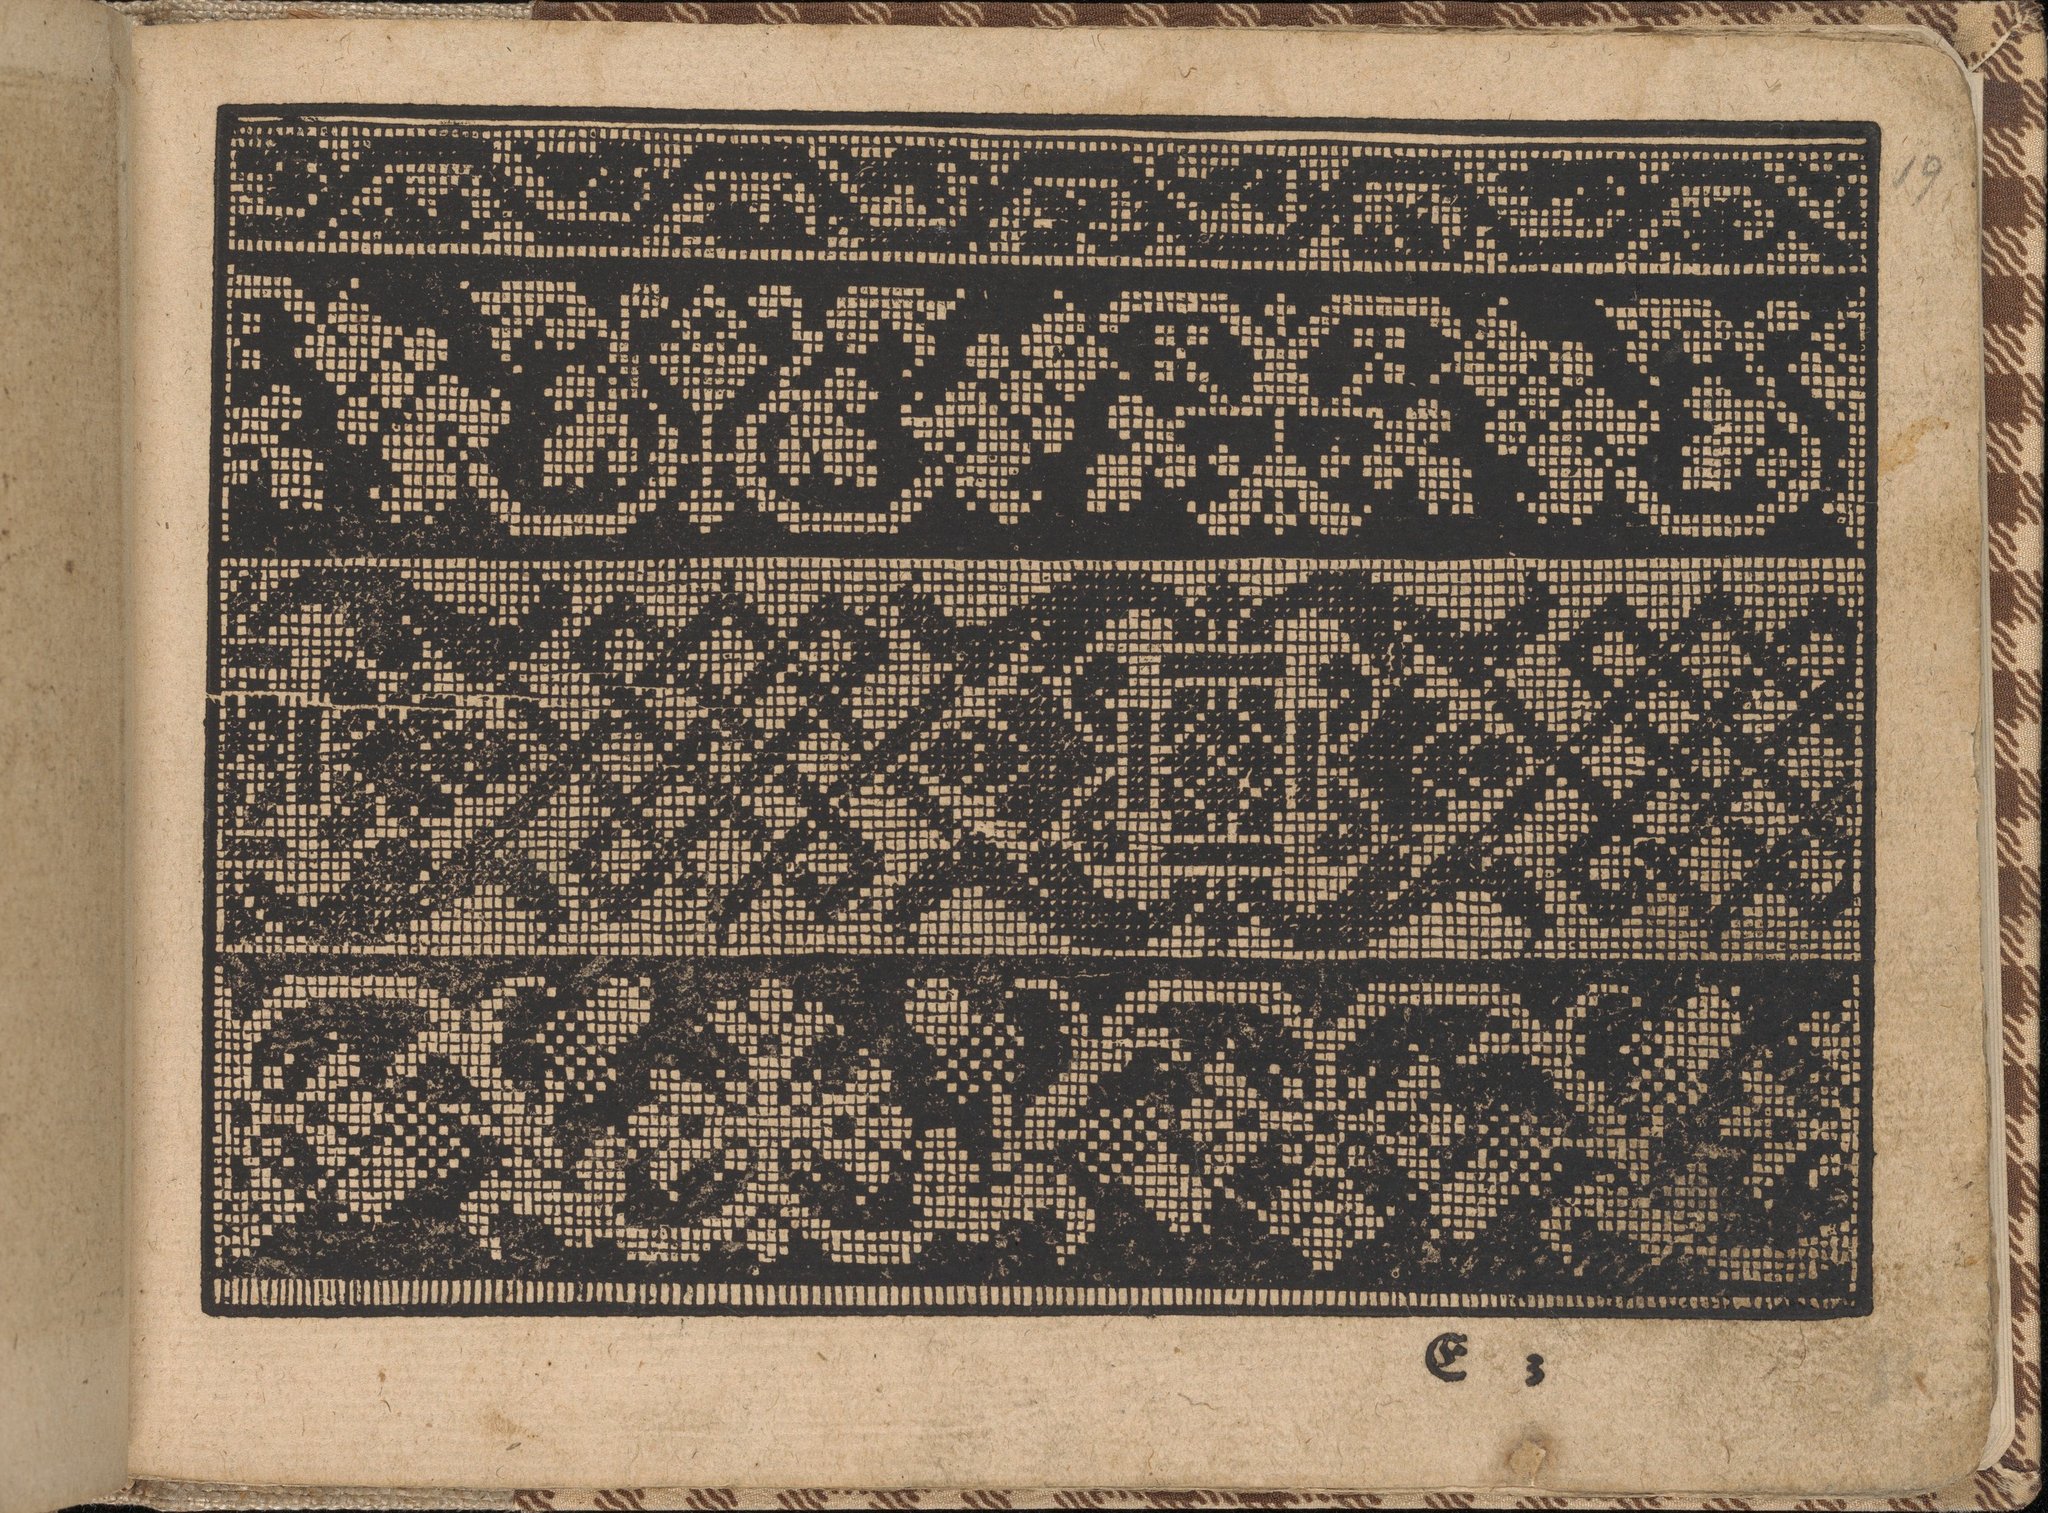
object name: book print ornament architecture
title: New Künstlichs Modelbuch (Page 19 recto)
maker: bernhard jobin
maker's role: publisher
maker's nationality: swiss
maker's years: 1535-1597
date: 1600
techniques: woodcut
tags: ornament